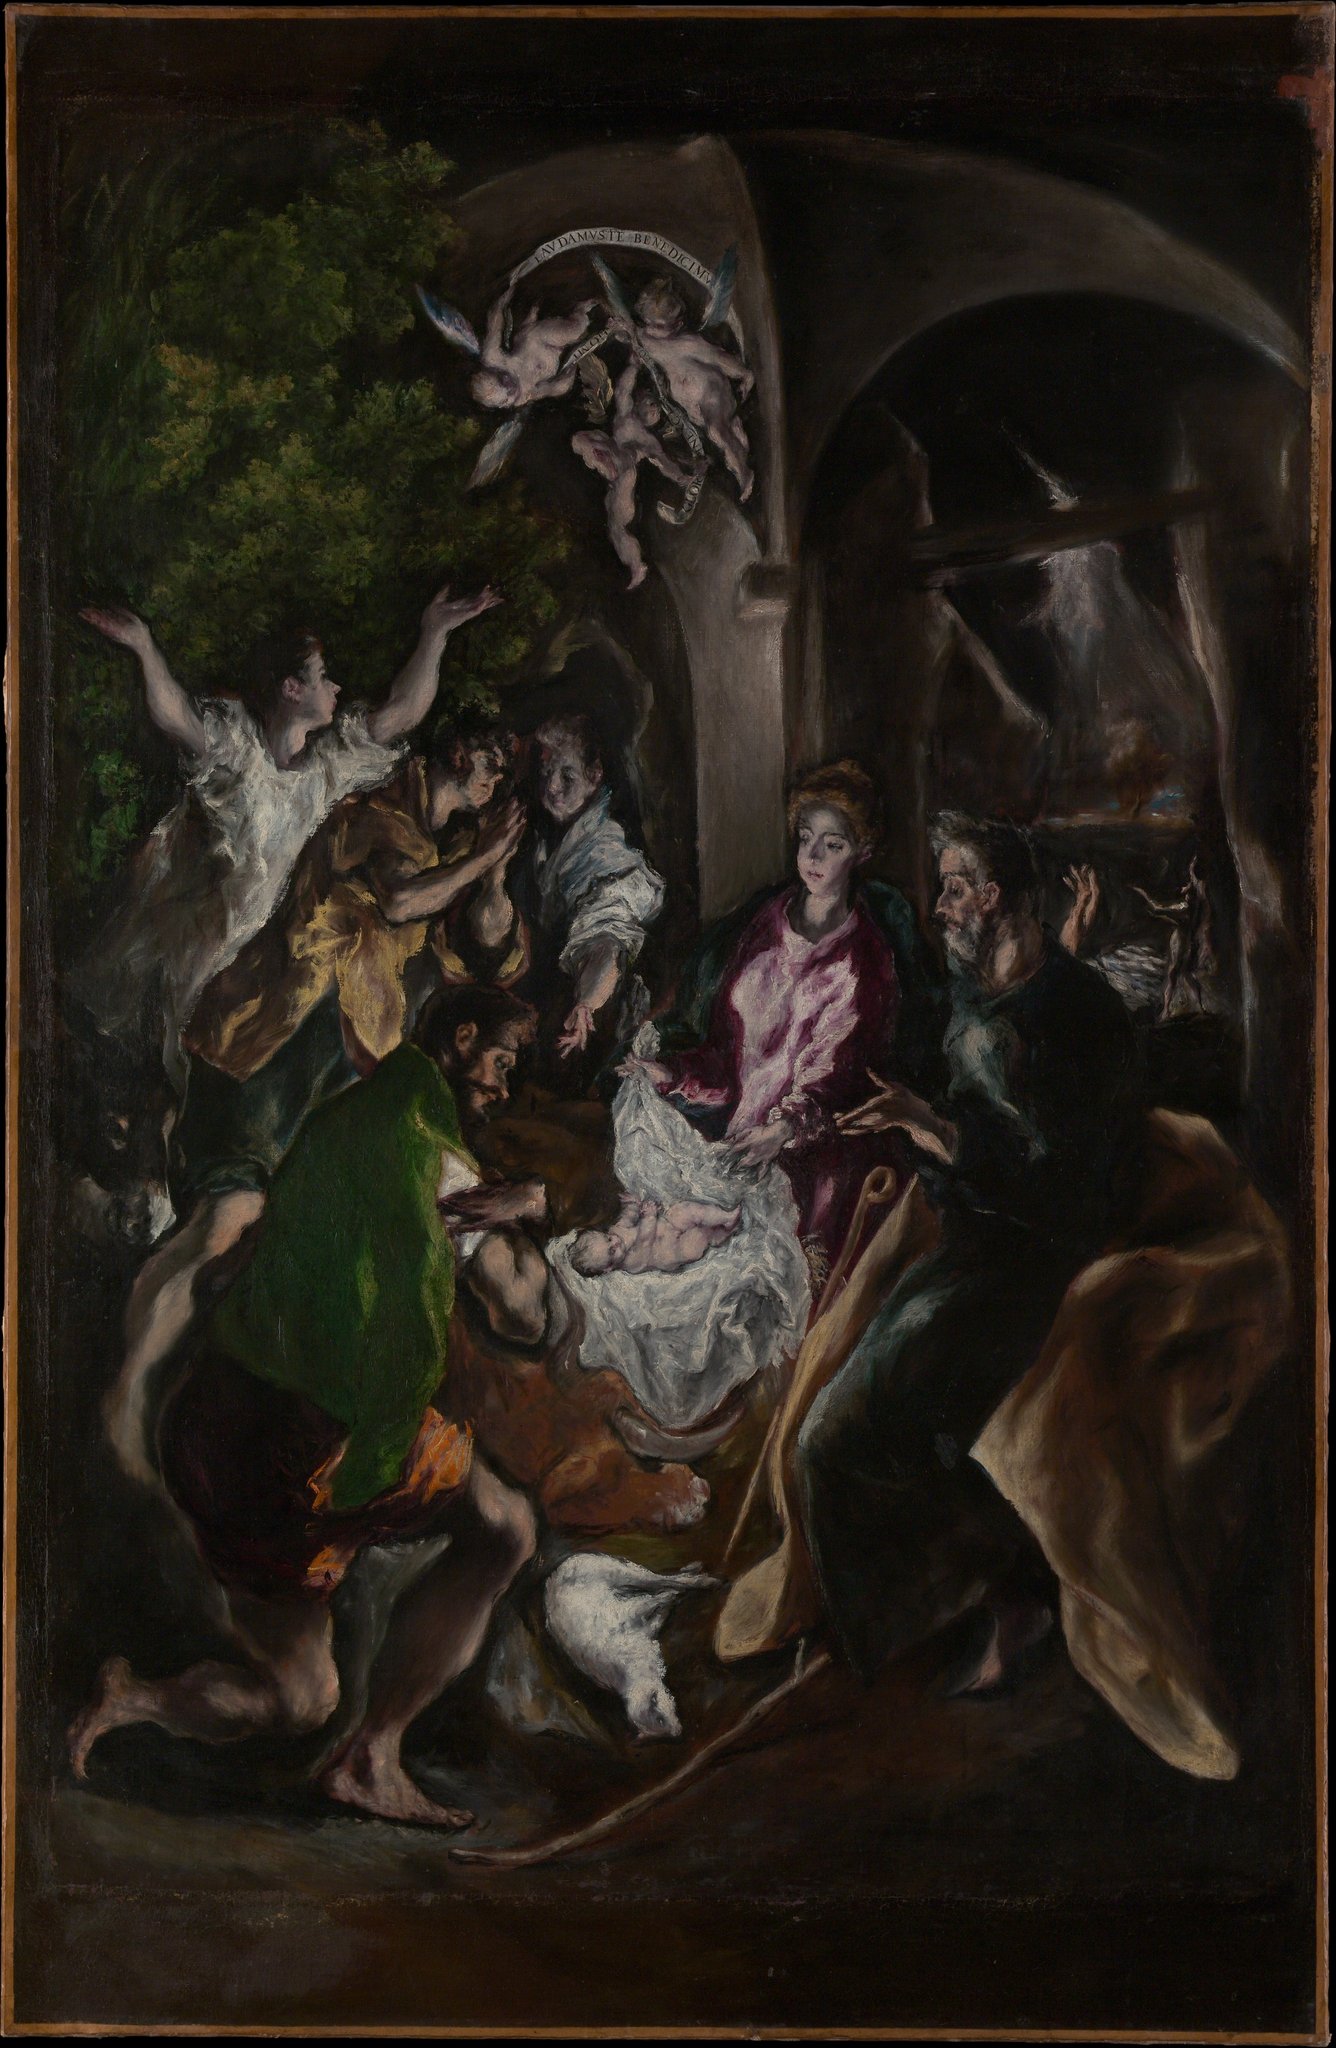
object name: painting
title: The Adoration of the Shepherds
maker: el greco (domenikos theotokopoulos)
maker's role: artist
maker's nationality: greek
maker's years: 1540-1614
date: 1605-1610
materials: canvas, oil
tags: cows,lambs,virgin mary,jesus,adoration of the shepherds